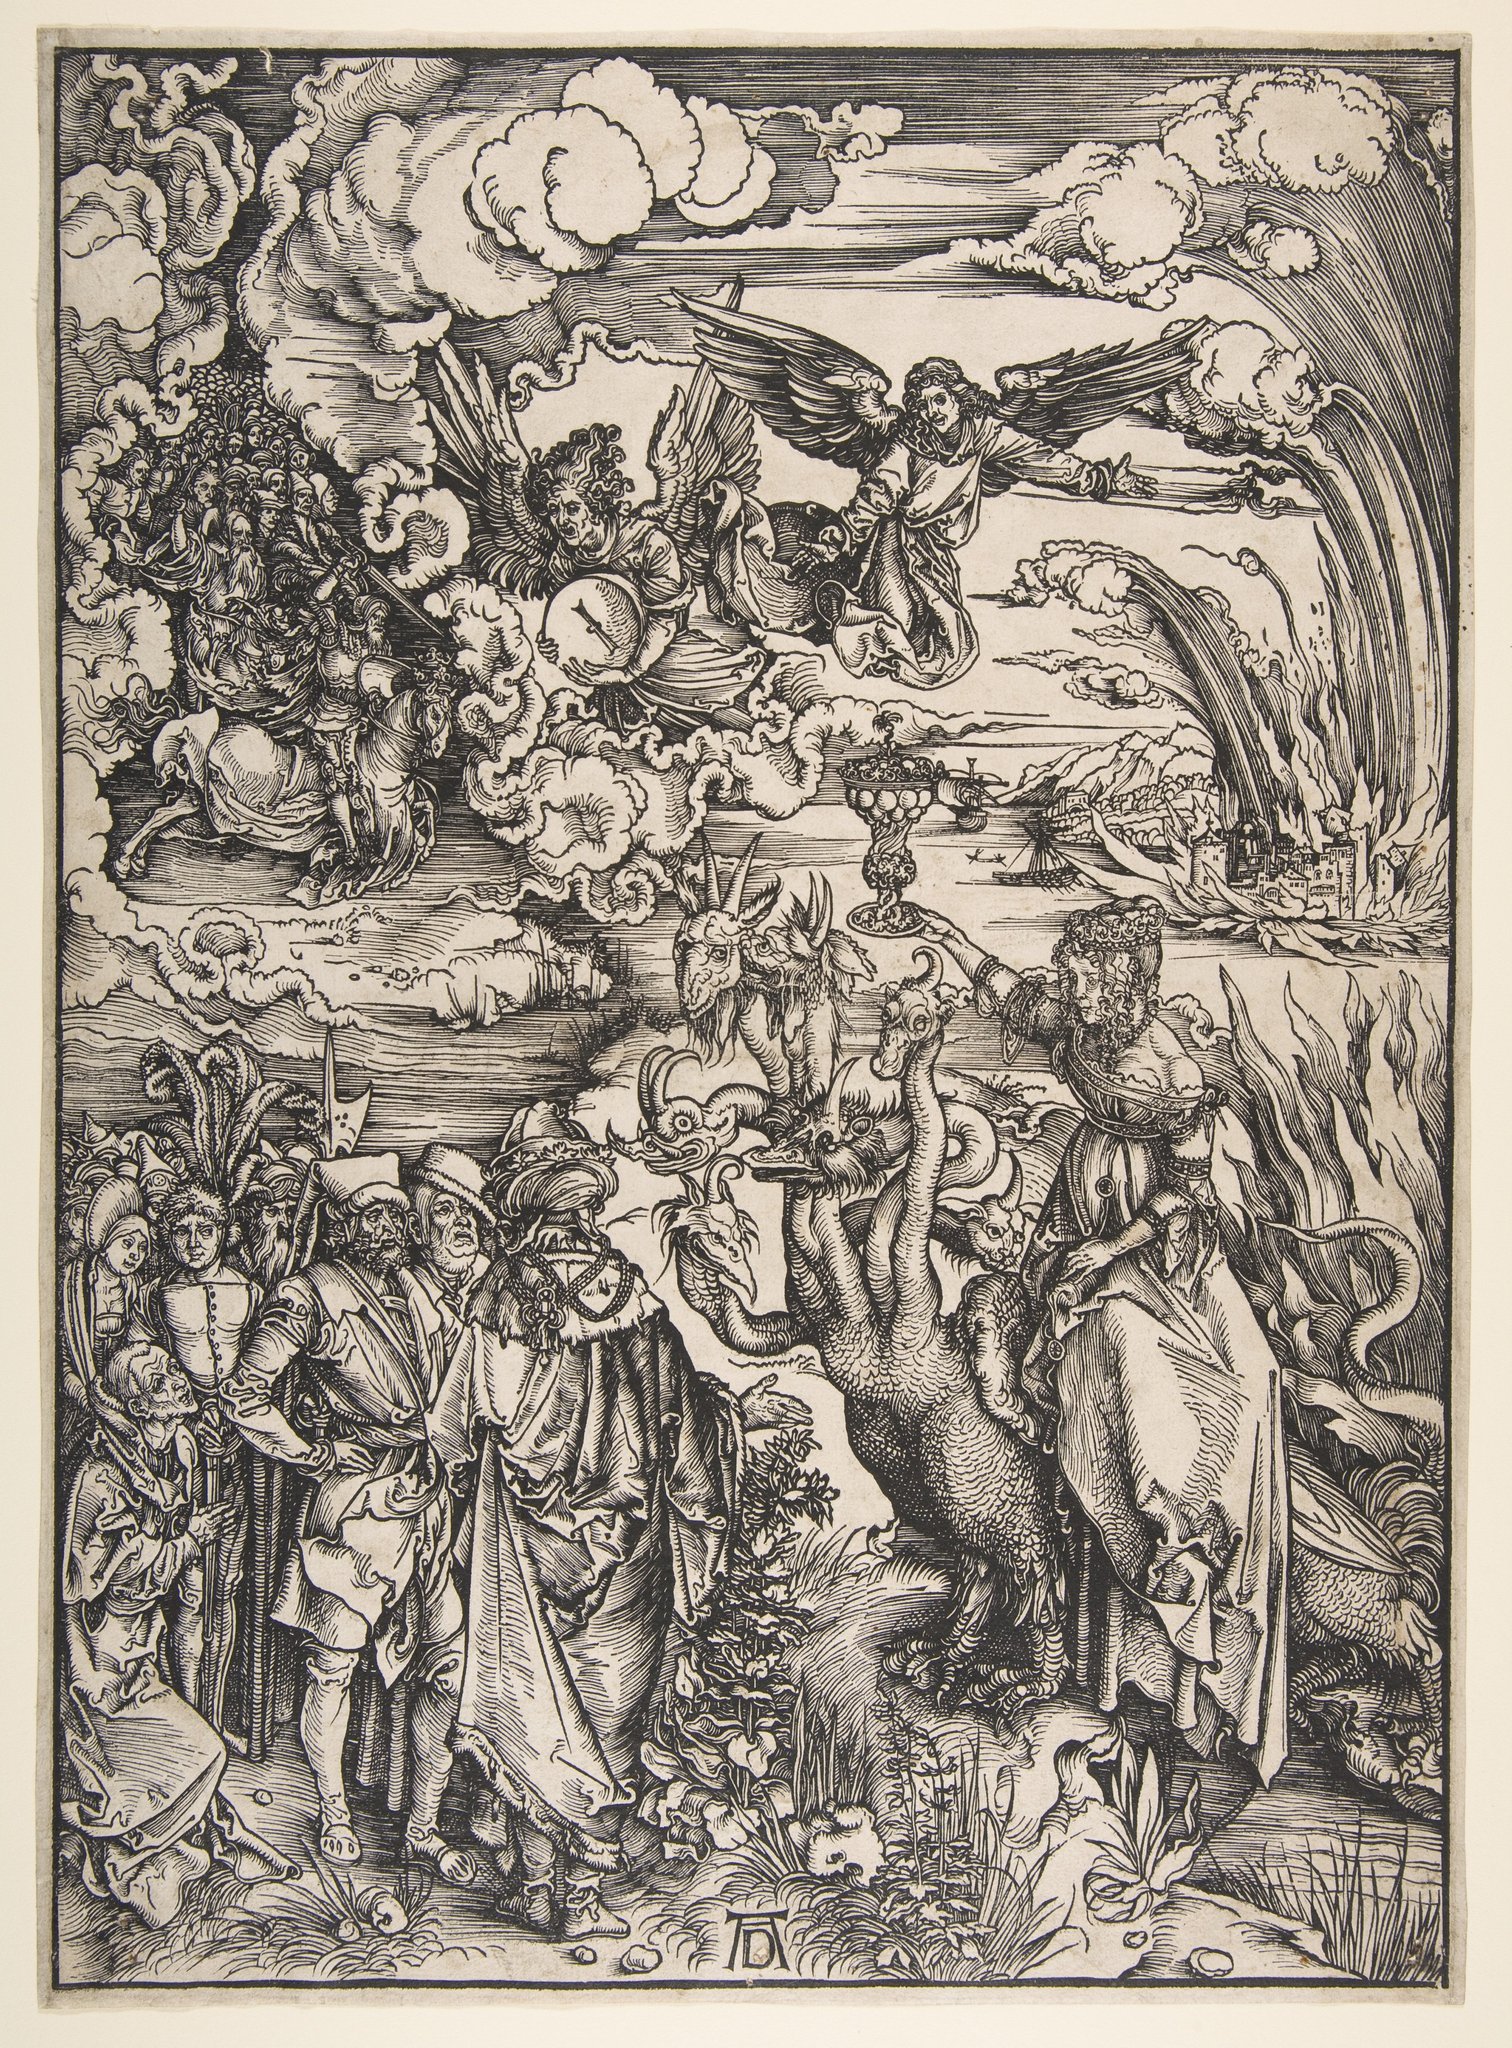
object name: print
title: The Whore of Babylon, from "The Apocalypse"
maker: albrecht dürer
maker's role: artist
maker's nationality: german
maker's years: 1471-1528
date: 1498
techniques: woodcut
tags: men,women,monsters,apocalypse